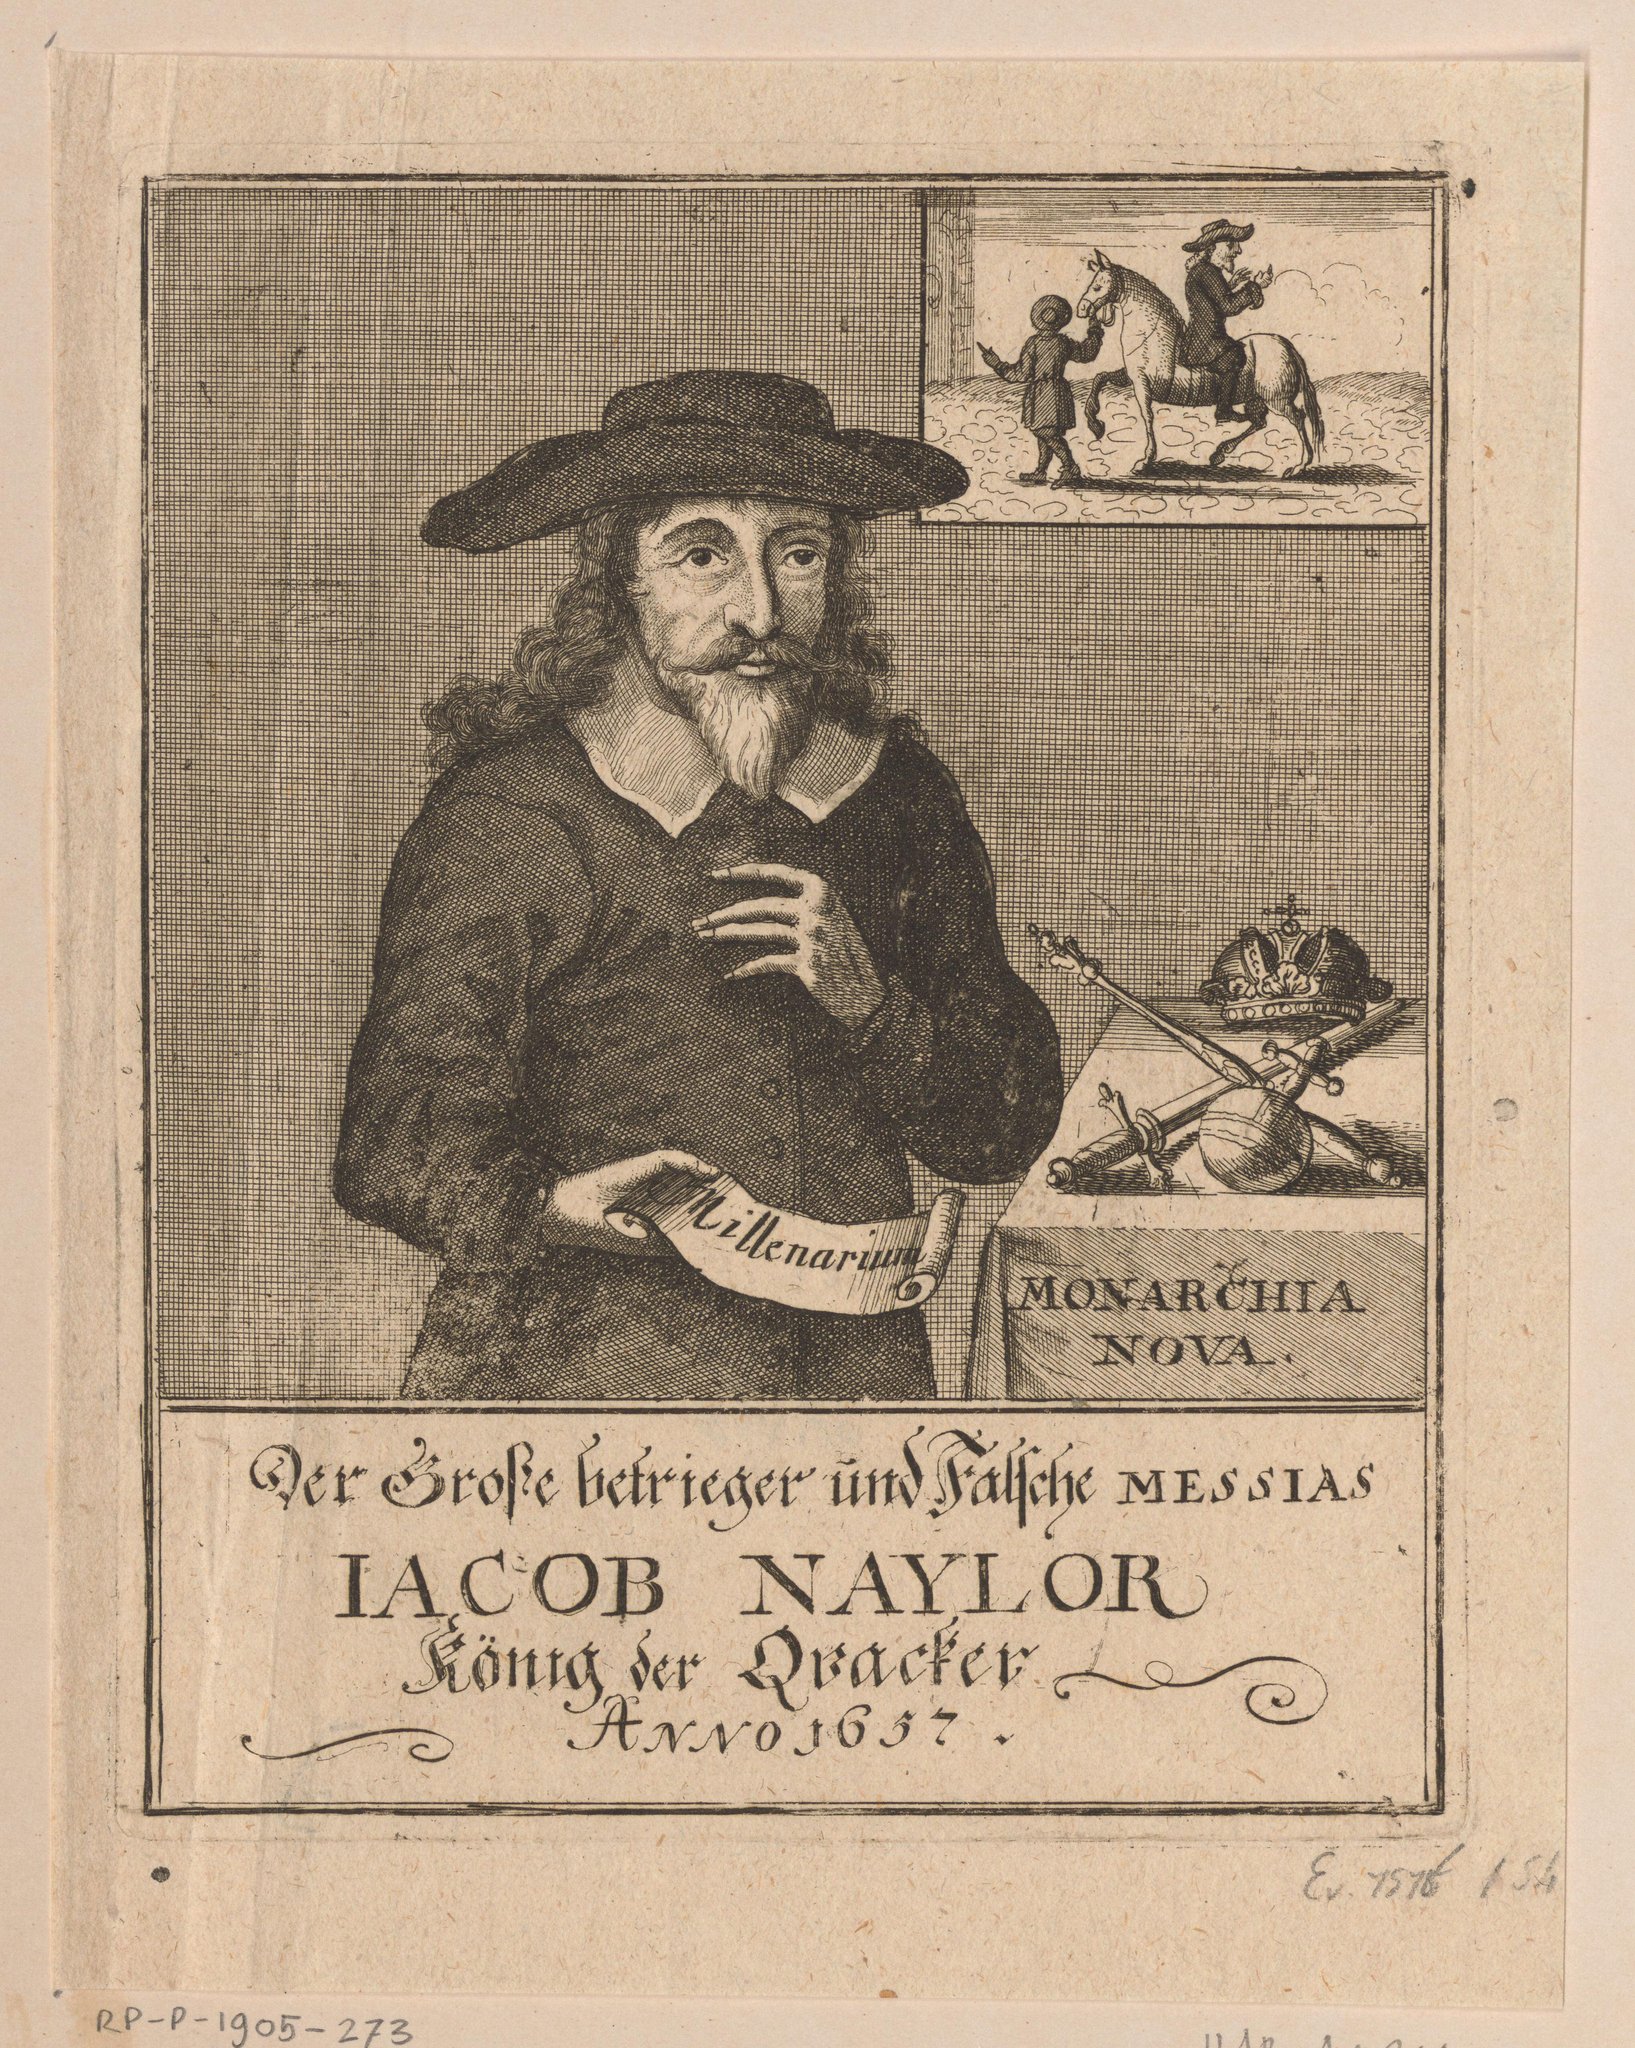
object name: print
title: Portret van James Nayler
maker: Anonymous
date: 1702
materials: paper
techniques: etching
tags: protestant churches and denominations, historical persons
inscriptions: collector's mark: Lugt 2228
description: Prent mogelijk uit: Müller, Johann. Alte und neue Schwarm-Geister-Bruth, und Quäcker-Greuel (...). S.l.s.n., 1702. Of uit: Müller. Johann. Quäcker-Greuel, das ist: Abscheuliche, auffrürische, verdammliche Irthurm der neueun Schwermer (...). Köthen: Wilhelm Andreas Meyer, 1702.